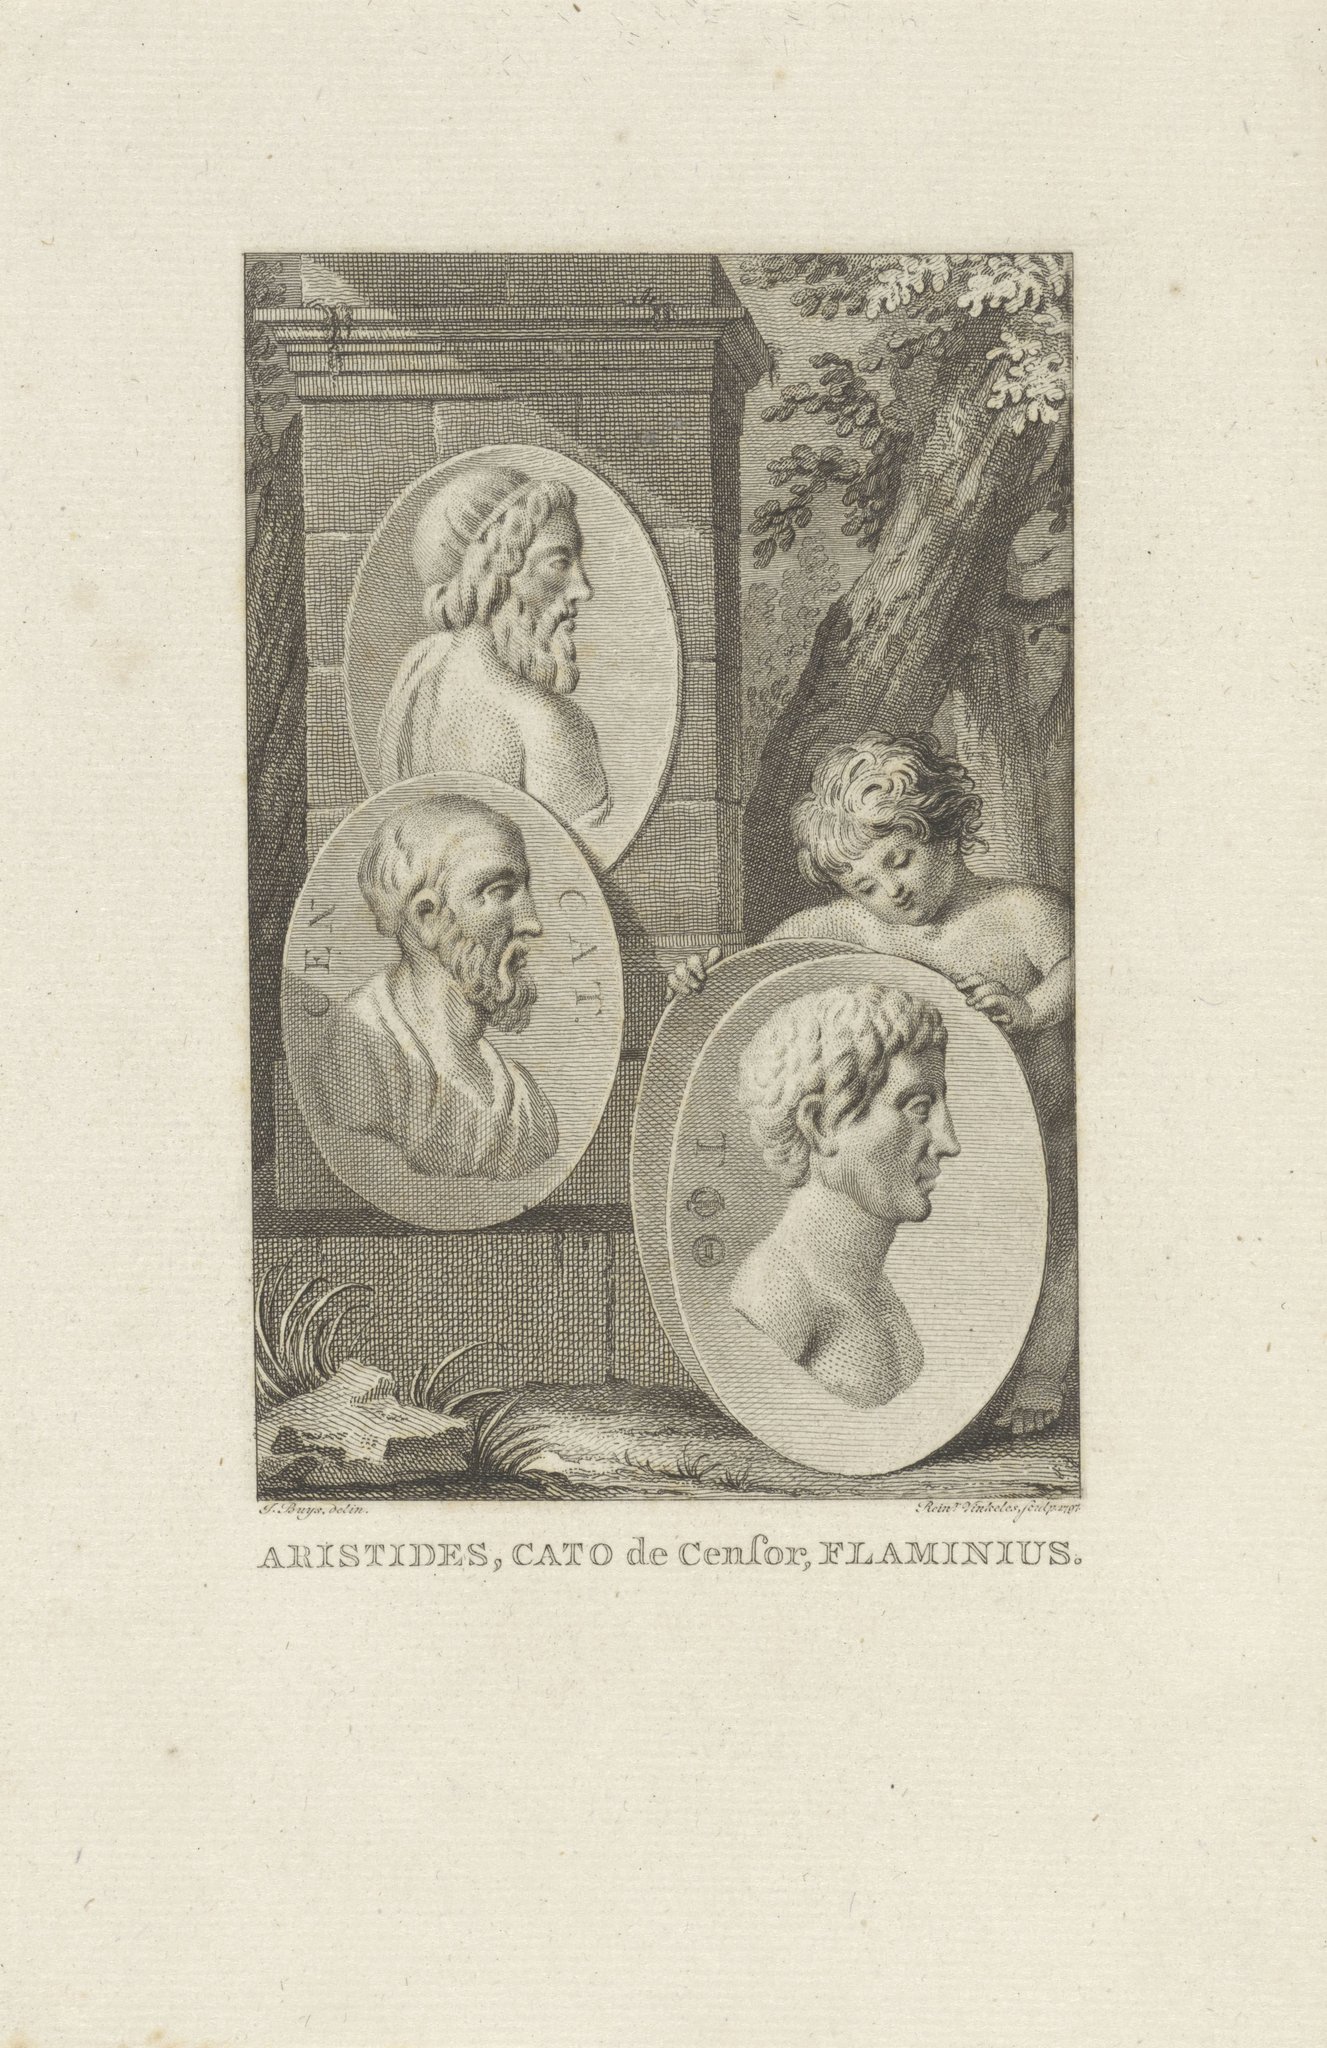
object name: print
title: Medaillons met portretten van Aristides, Cato de Oude en Flaminius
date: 1789-1809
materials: paper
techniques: etching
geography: amsterdam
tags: (story of) marcus porcius cato the elder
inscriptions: collector's mark: Lugt 240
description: Prent ook gebruikt als boekillustratie in: Plutarchus [bewerkt door E. Wassenbergh en H. Bosscha]. De levens van doorluchtige Grieken en Romeinen, onderling vergeleeken (...). 12 dln. Amsterdam: Johannes Allart, 1789-1809.